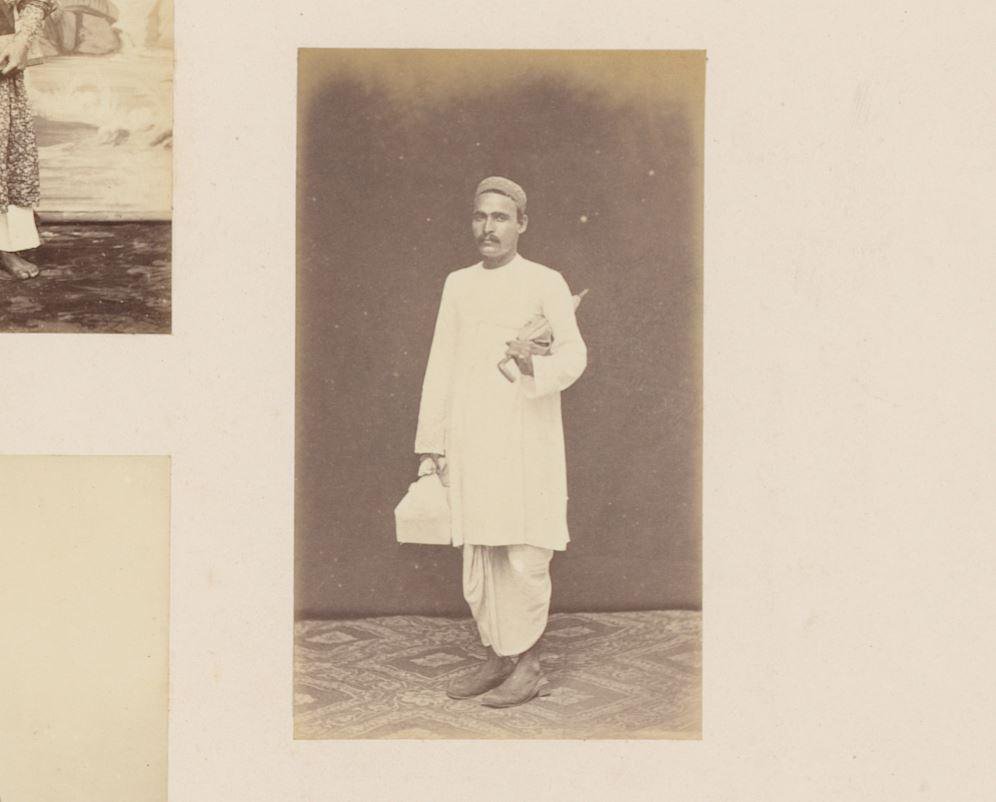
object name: photograph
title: Portret van een Indische man in lang gewaad met paraplu onder de arm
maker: Anonymous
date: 1880-1883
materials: photographic support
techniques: albumen print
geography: dutch east indies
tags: studio requisites ~ photographer, adult man, umbrella, dutch east indies, the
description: Onderdeel van Reisalbum met opnames van bezienswaardigheden in Egypte, Nederlands-Indië, Singapore en Ceylon.